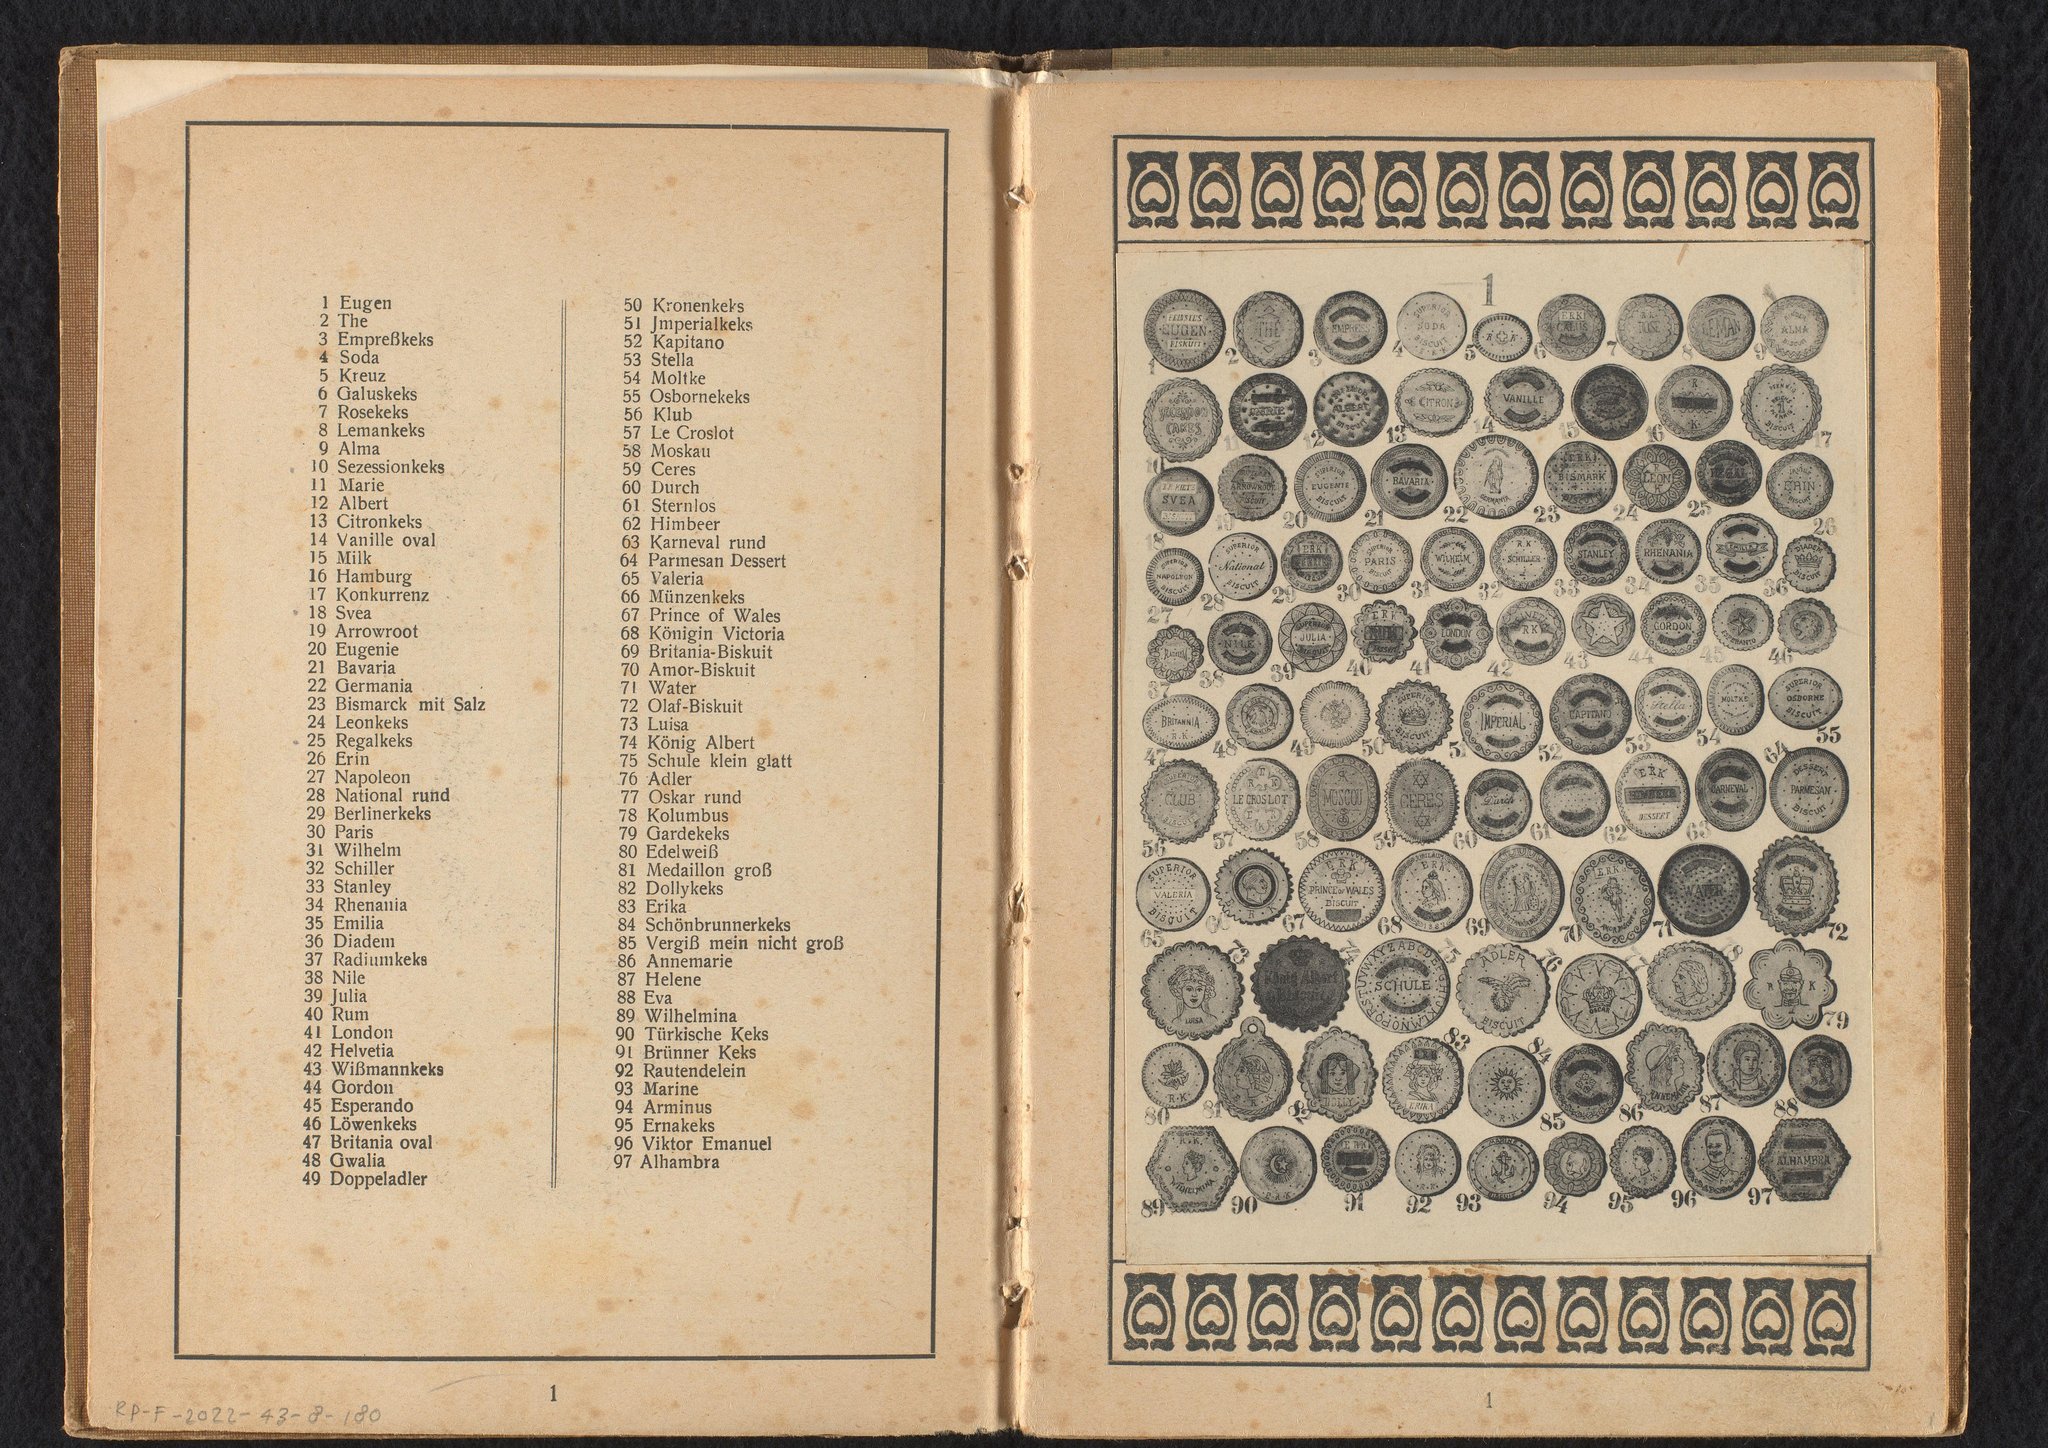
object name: photomechanical print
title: Verschillende Engelse koekjes en biscuits als voorbeeld bij recepten 1-97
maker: Anonymous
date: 1900-1905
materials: paper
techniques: photograph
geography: bad langensalza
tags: pastry cook, moulds for biscuits, biscuits